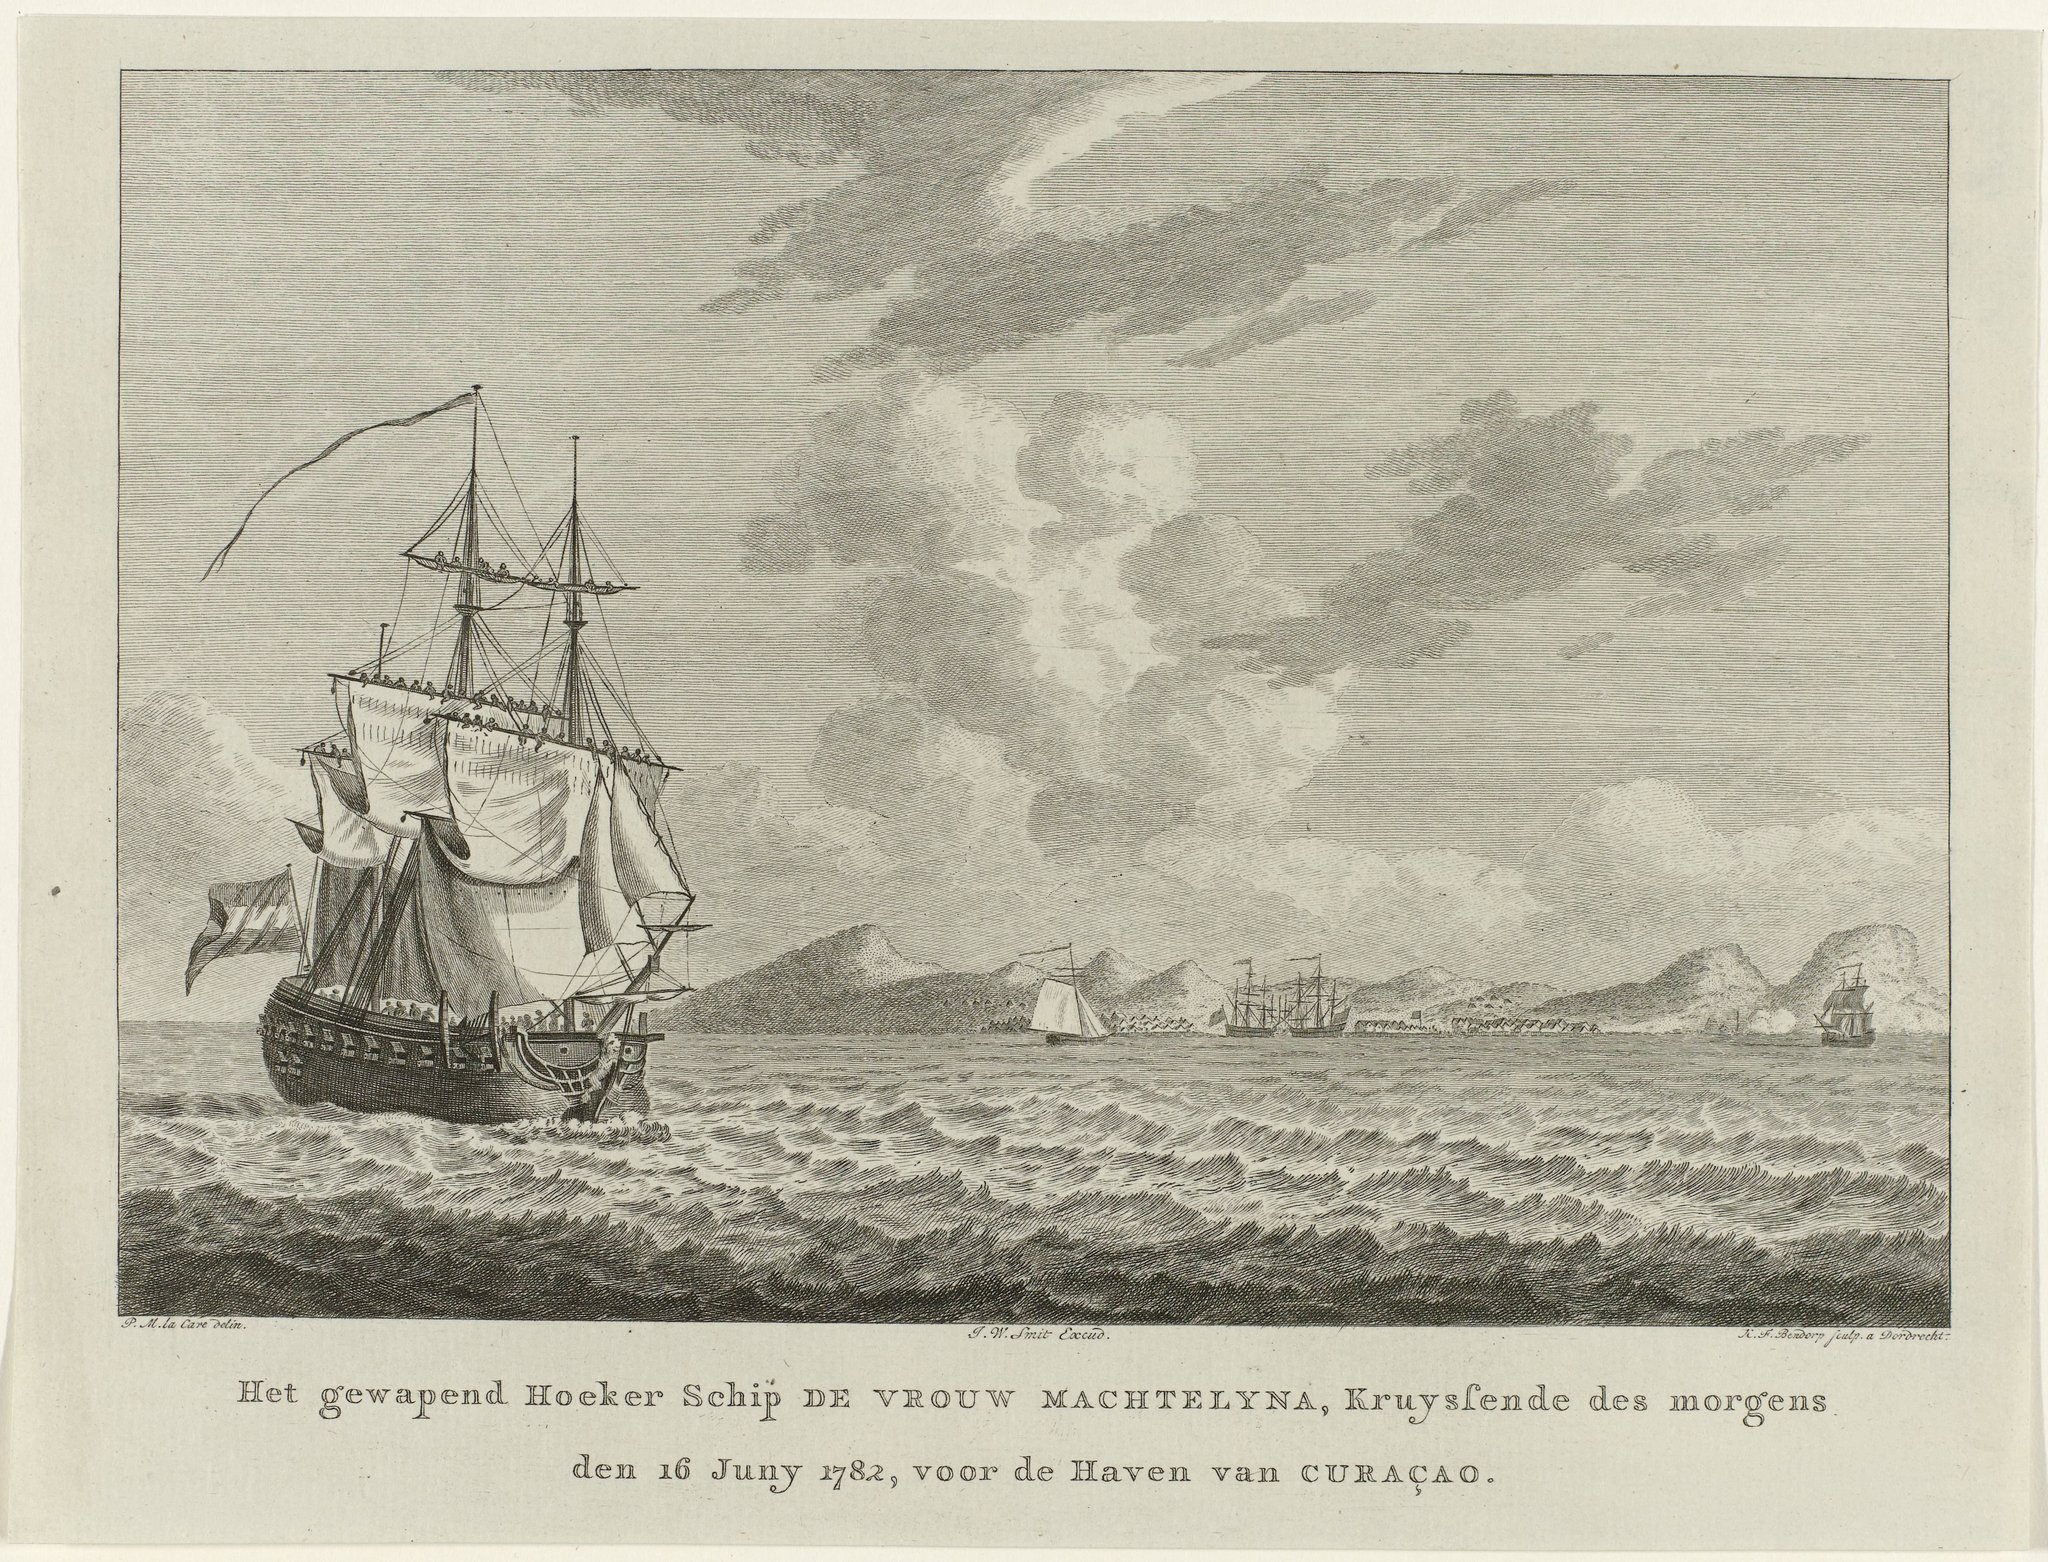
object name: print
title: Het gewapend Hoeker Schip De Vrouw Machtelyna, Kruysende des morgens den 16 Juny 1782, voor de Haven van Curaçao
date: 1782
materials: paper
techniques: engraving, etching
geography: amsterdam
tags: battle (+ naval force), fourth anglo-dutch war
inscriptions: collector's mark: Lugt 2228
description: Het Nederlandse gewapende hoekerschip de Vrouw Machtelyna varend voor de haven van Curaçao, 16 juni 1782. Onderdeel van een serie van drie platen van het gevecht van het hoekerschip Vrouw Machtelyna met het Engelse fregat Diamant voor de haven van Curaçao op 16 juni 1782. Bij deze prentserie behoort een aankondiging van de uitgever.